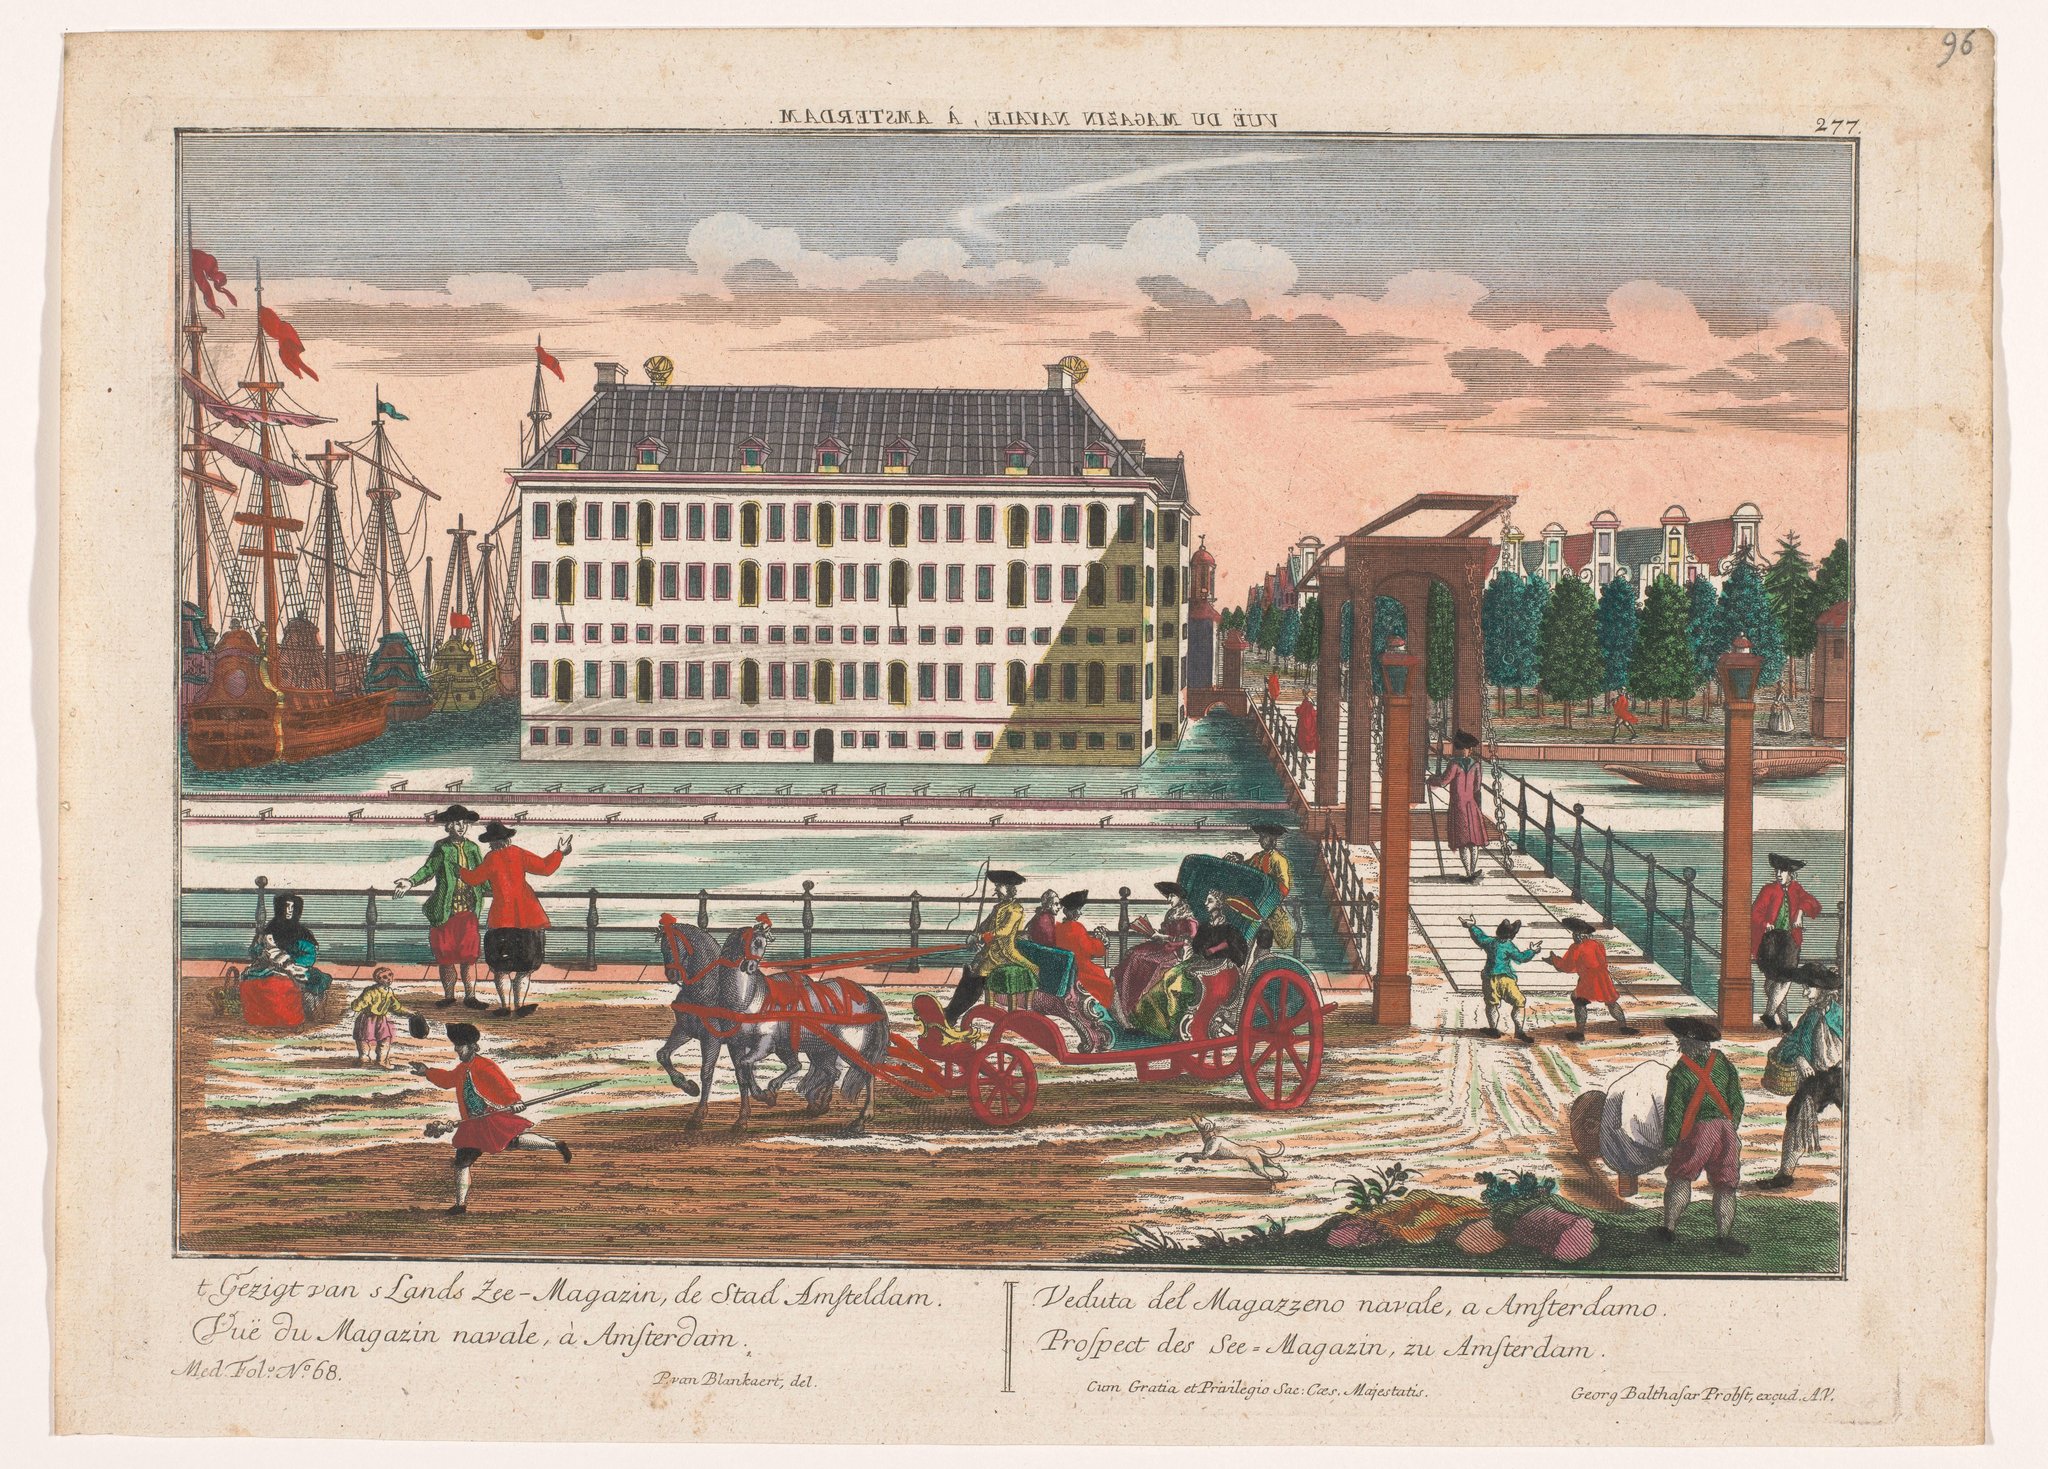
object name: print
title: Prospect des See-Magazin, zu Amsterdam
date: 1742-1801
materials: paper, watercolor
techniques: brush, etching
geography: augsburg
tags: large-scale structure for storage, e.g.: warehouse, depot, silo, bridge in city across river, canal, etc. (+ city(-scape) with figures, staffage), sailing-ship, sailing-boat, rowing-boat, canoe, etc., four-wheeled vehicle drawn by two animals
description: De serie “Amsterdam”, met het nummer 68, bevat vier prenten met de nummers 274-277, waarvan dit nummer 277 is.